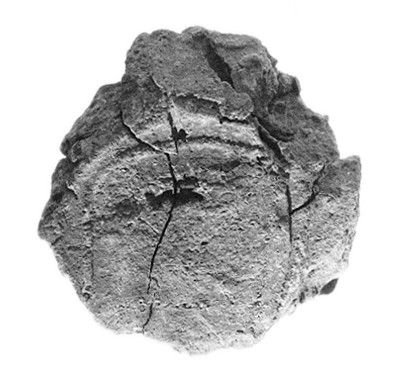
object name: sealing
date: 2030-1640 BCE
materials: clay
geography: egypt